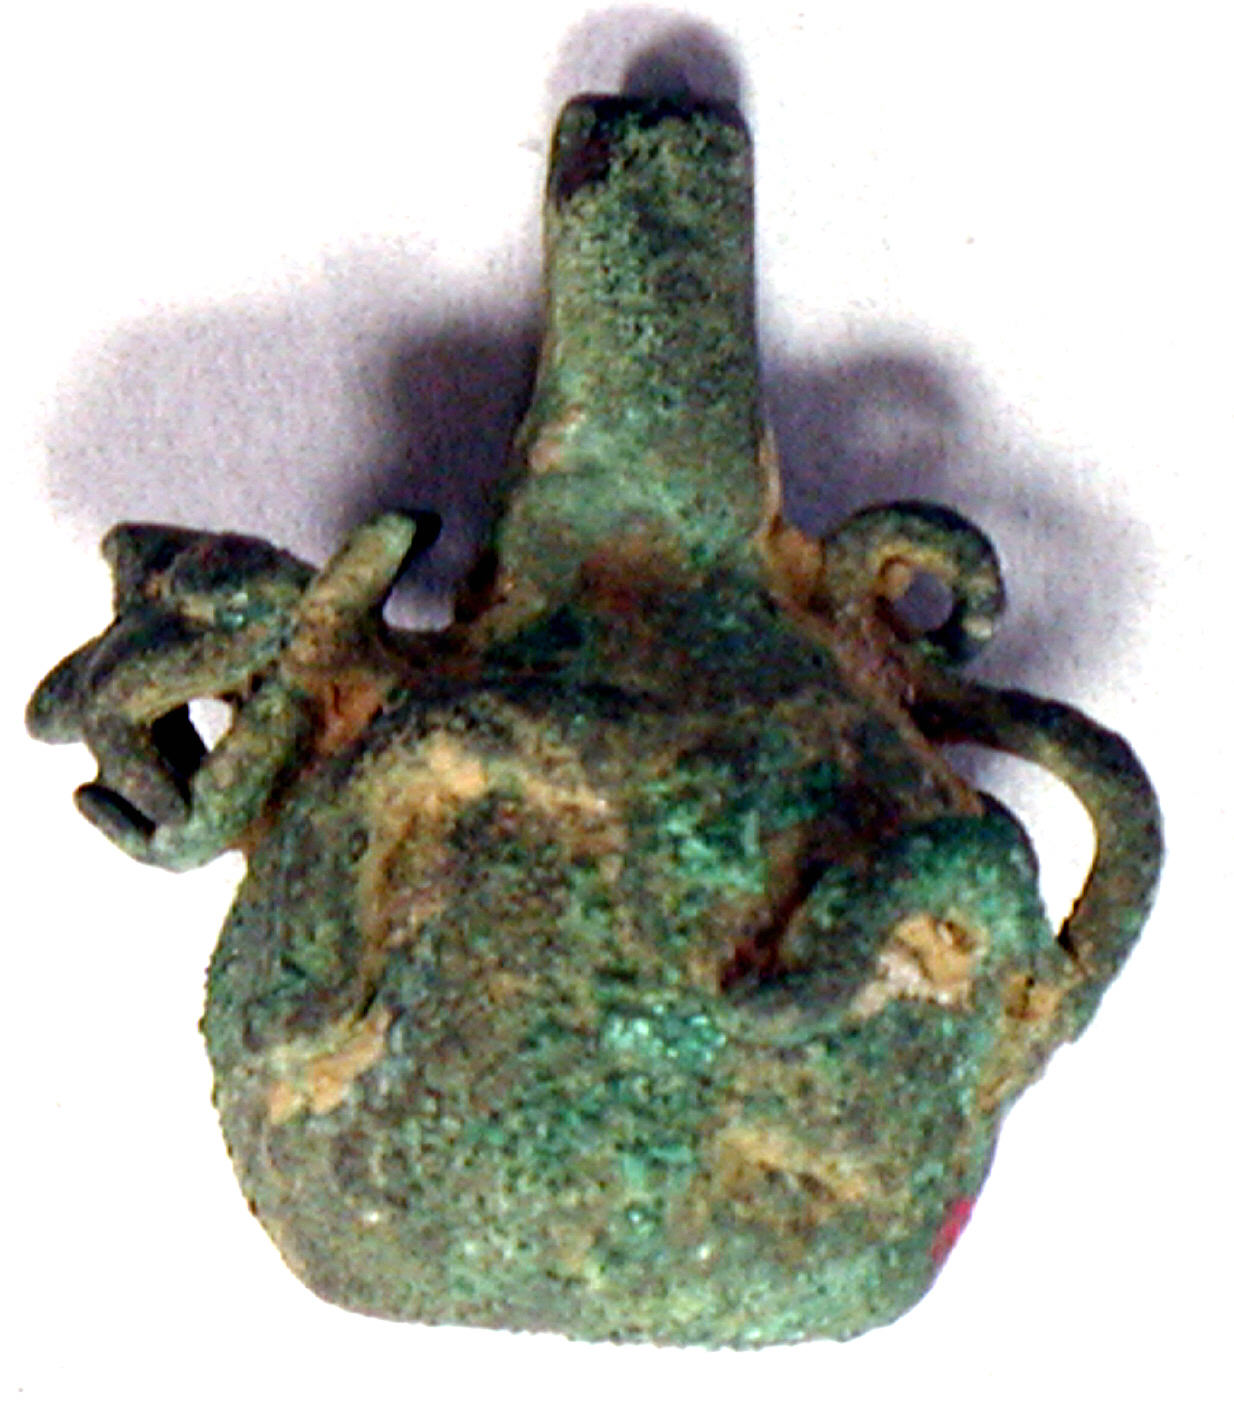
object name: bottle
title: Miniature Copper Single Spout Bottle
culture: peruvian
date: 1501-1600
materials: copper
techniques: casting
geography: peru